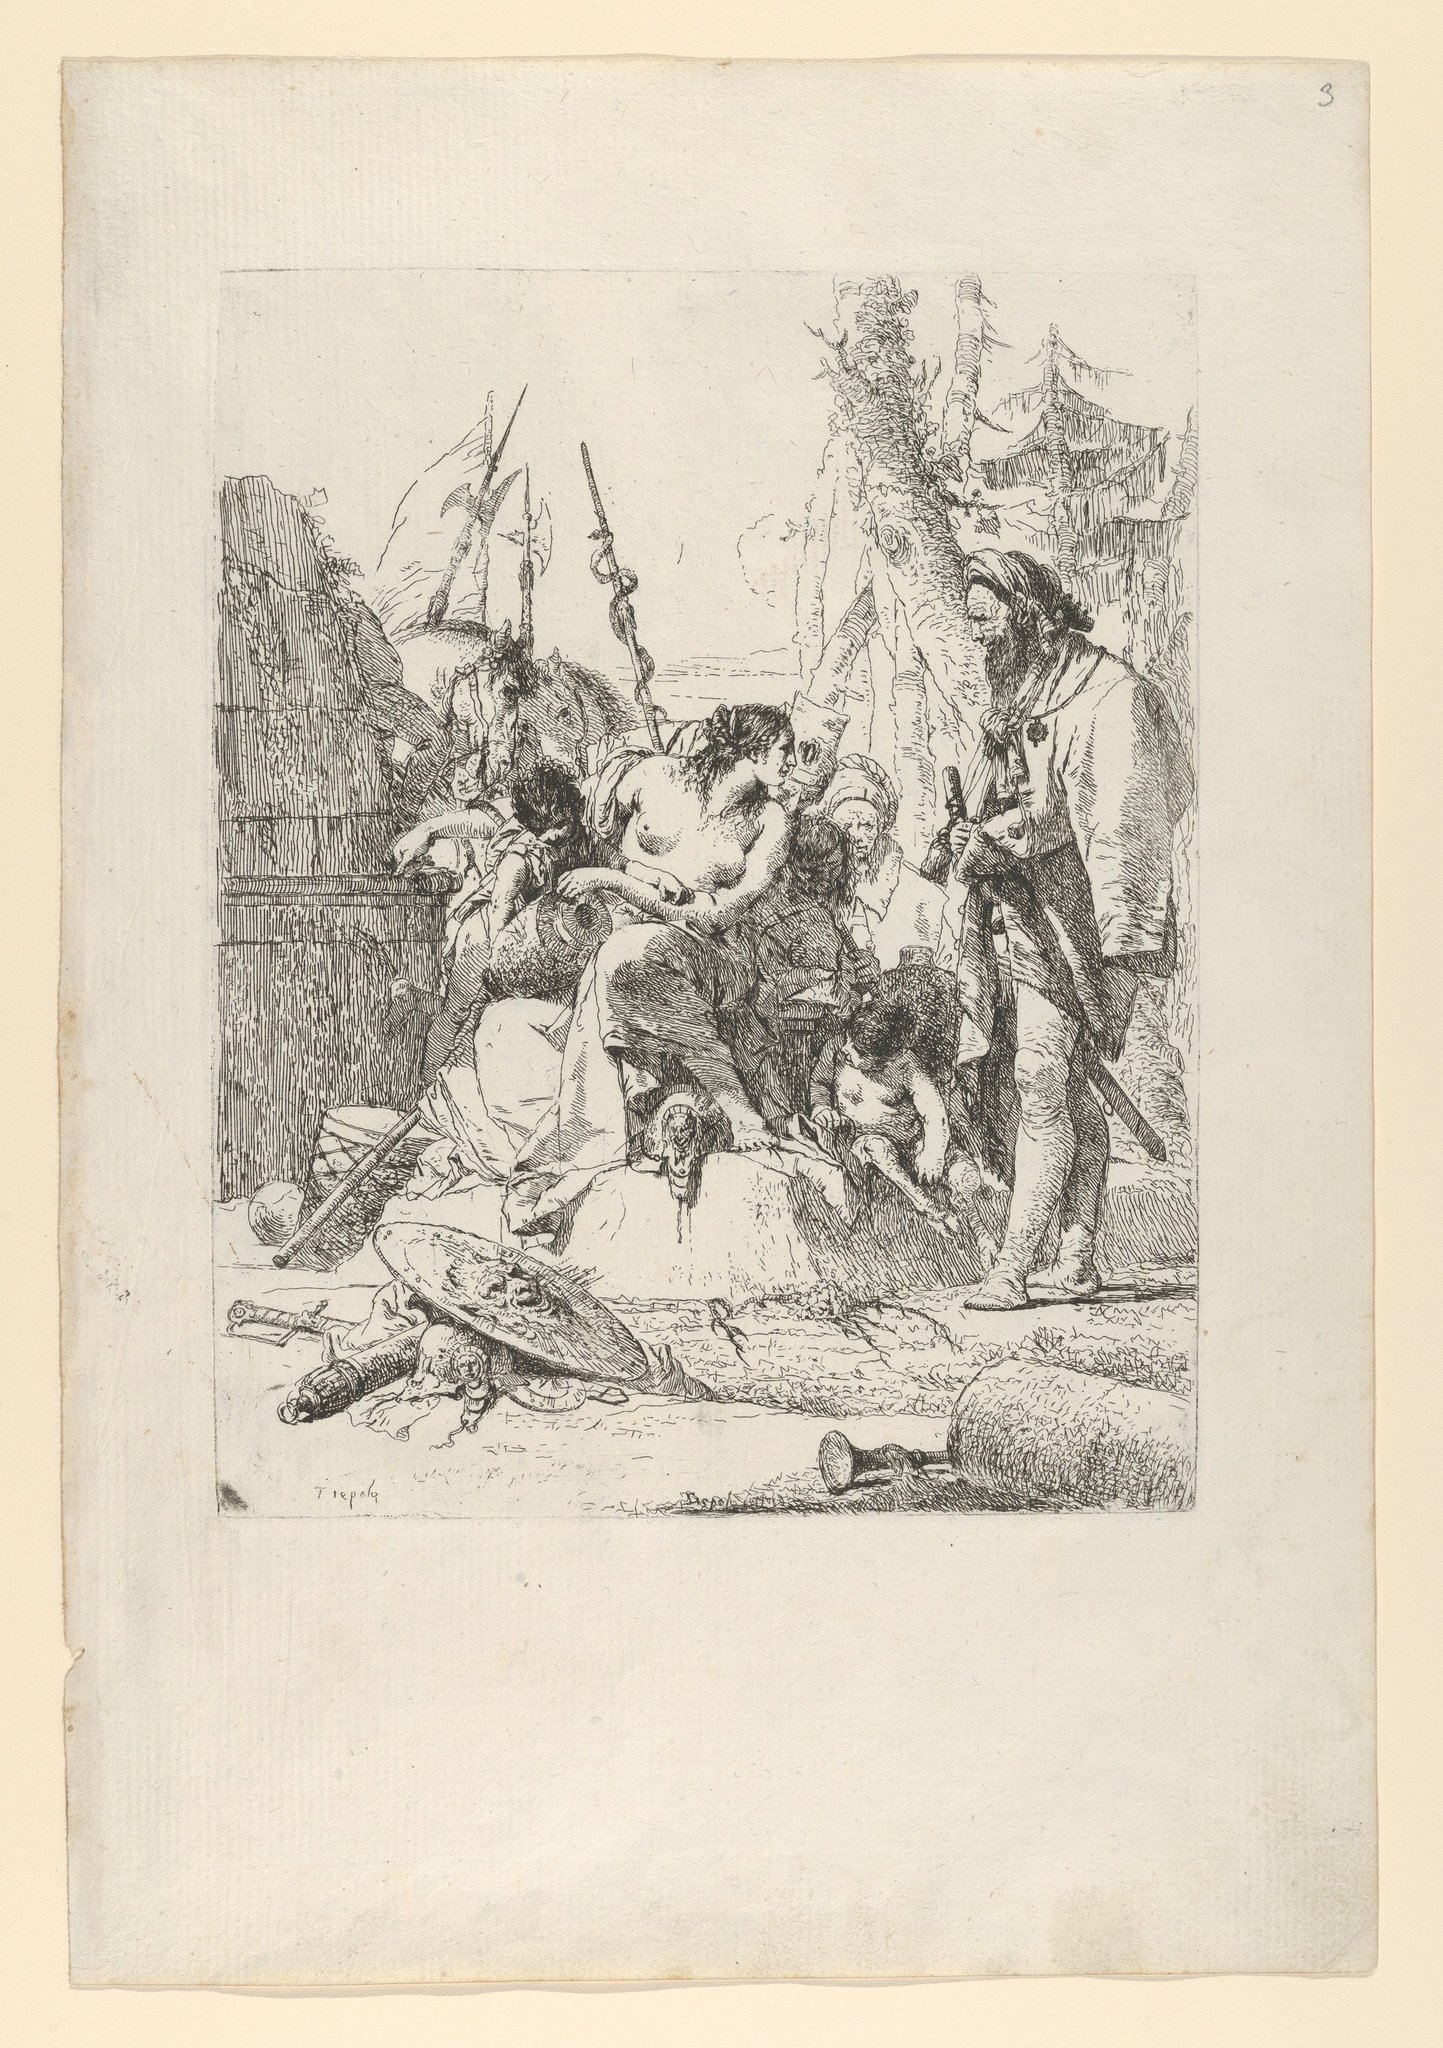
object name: print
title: Half-dressed Nymph with two children, surrounded by four men, from the Scherzi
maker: giovanni battista tiepolo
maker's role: artist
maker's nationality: italian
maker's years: 1696-1770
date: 1743-1750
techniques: etching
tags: children,men,nymphs